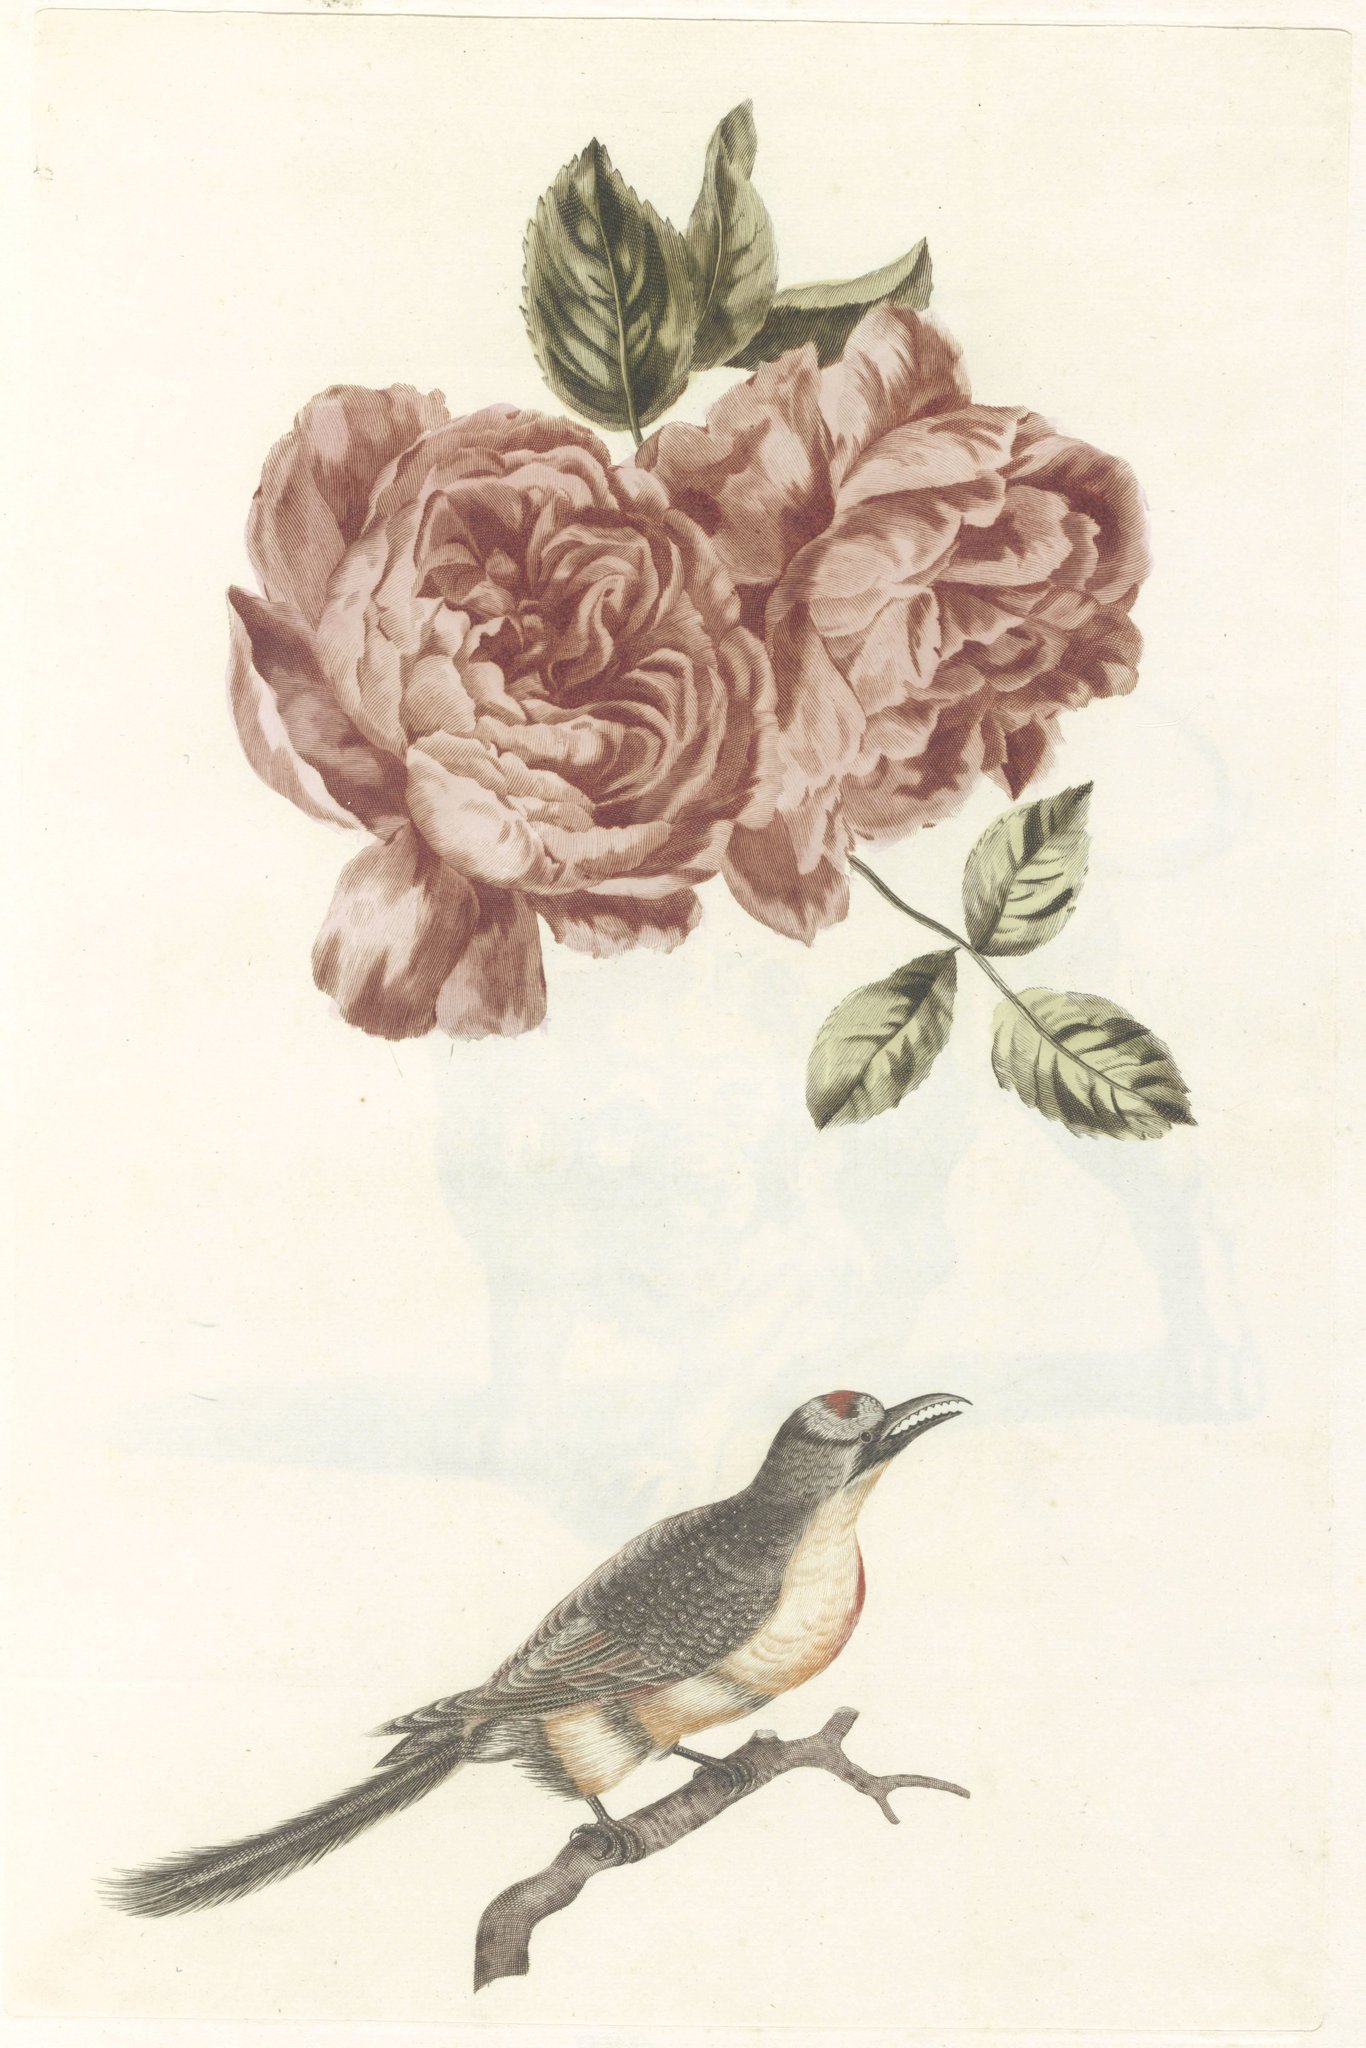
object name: album leaf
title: Twee rozen en een vogel met gekartelde bek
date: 1688-1698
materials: paper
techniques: printing, engraving, hand coloring, lithography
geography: netherlands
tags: birds, flowers: rose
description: Deze prent maakt deel uit van een album.